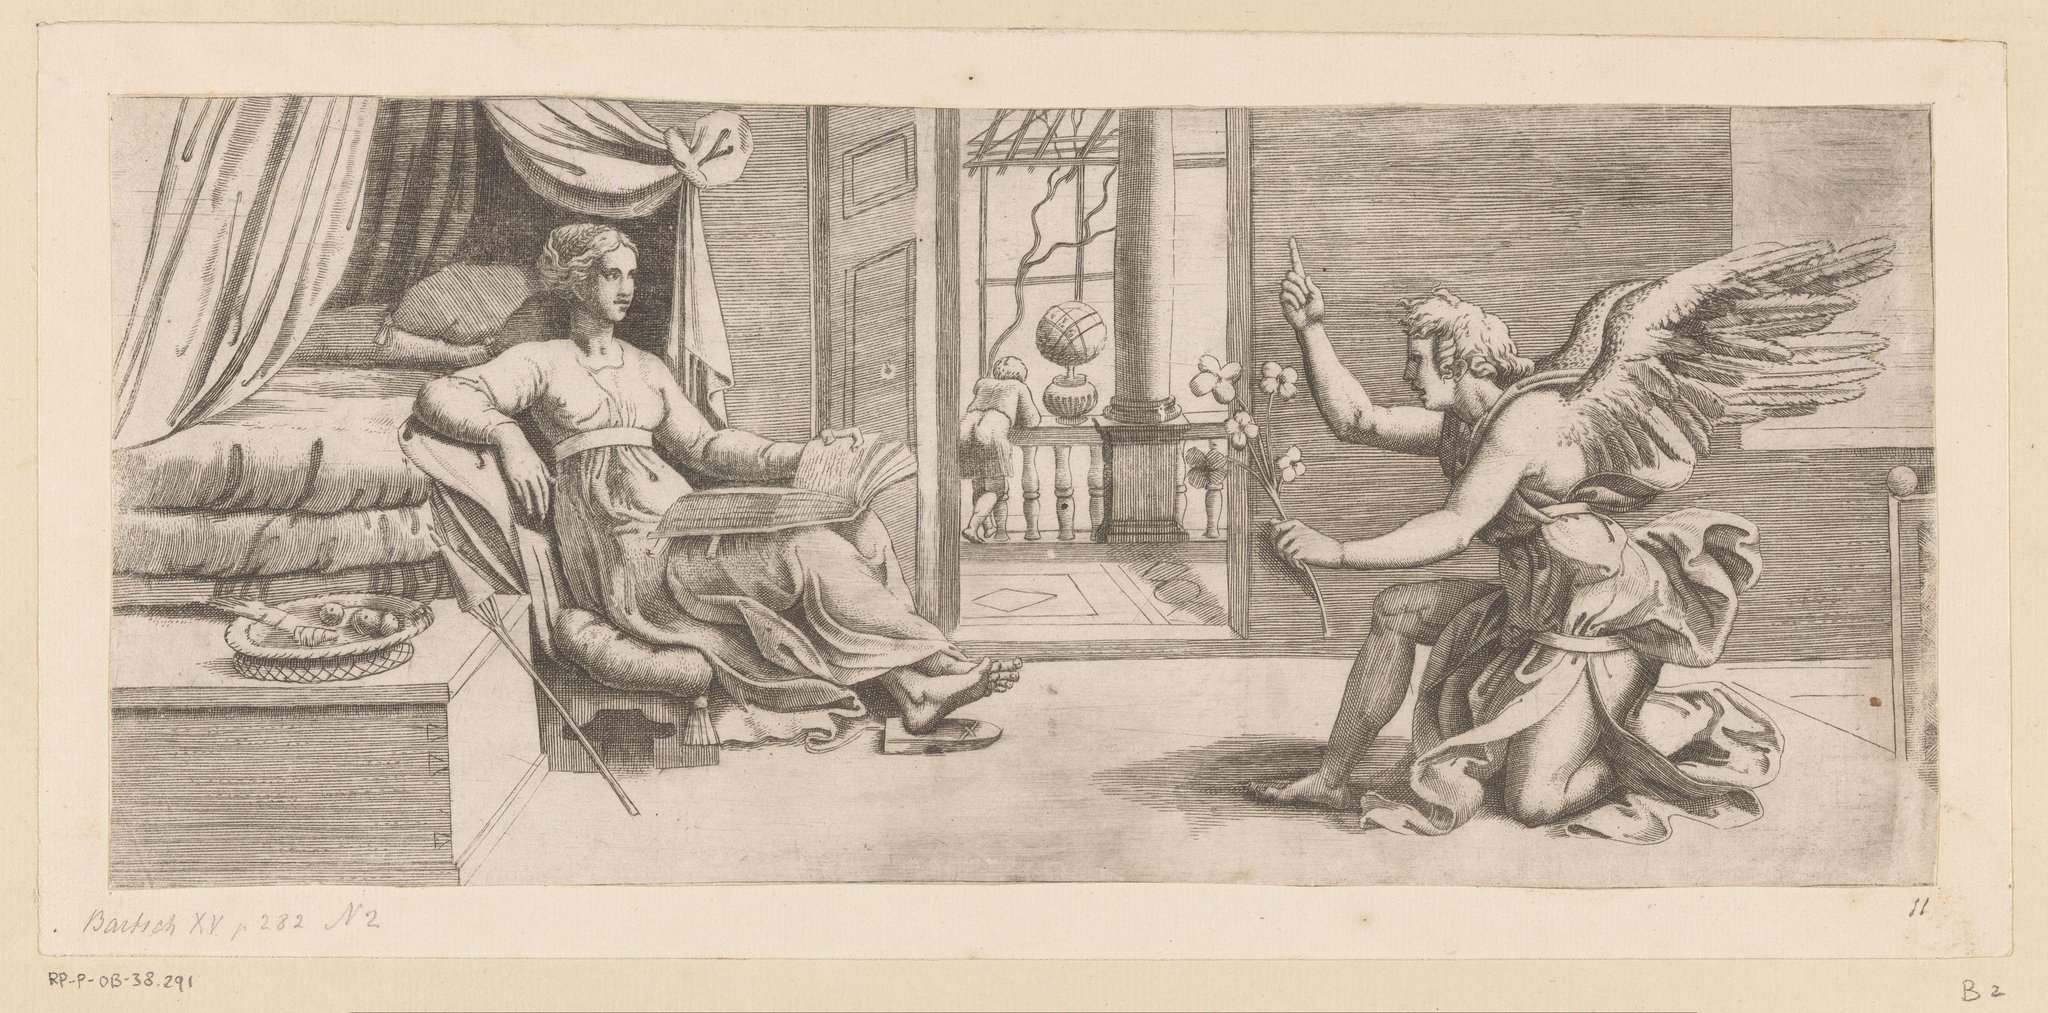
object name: print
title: Annunciatie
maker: enea vico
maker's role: draughtsman, print maker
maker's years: 1523-1567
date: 1533-1567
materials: paper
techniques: engraving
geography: italy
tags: the annunciation: mary, usually reading, is visited by the angel (sometimes a woman overhears the conversation) - aa - mary to the left, the angel to the right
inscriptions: collector's mark: Lugt 240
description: Links zit Maria met een opengeslagen boek. Rechts de engel Gabriël geknield met een lelie in de hand.